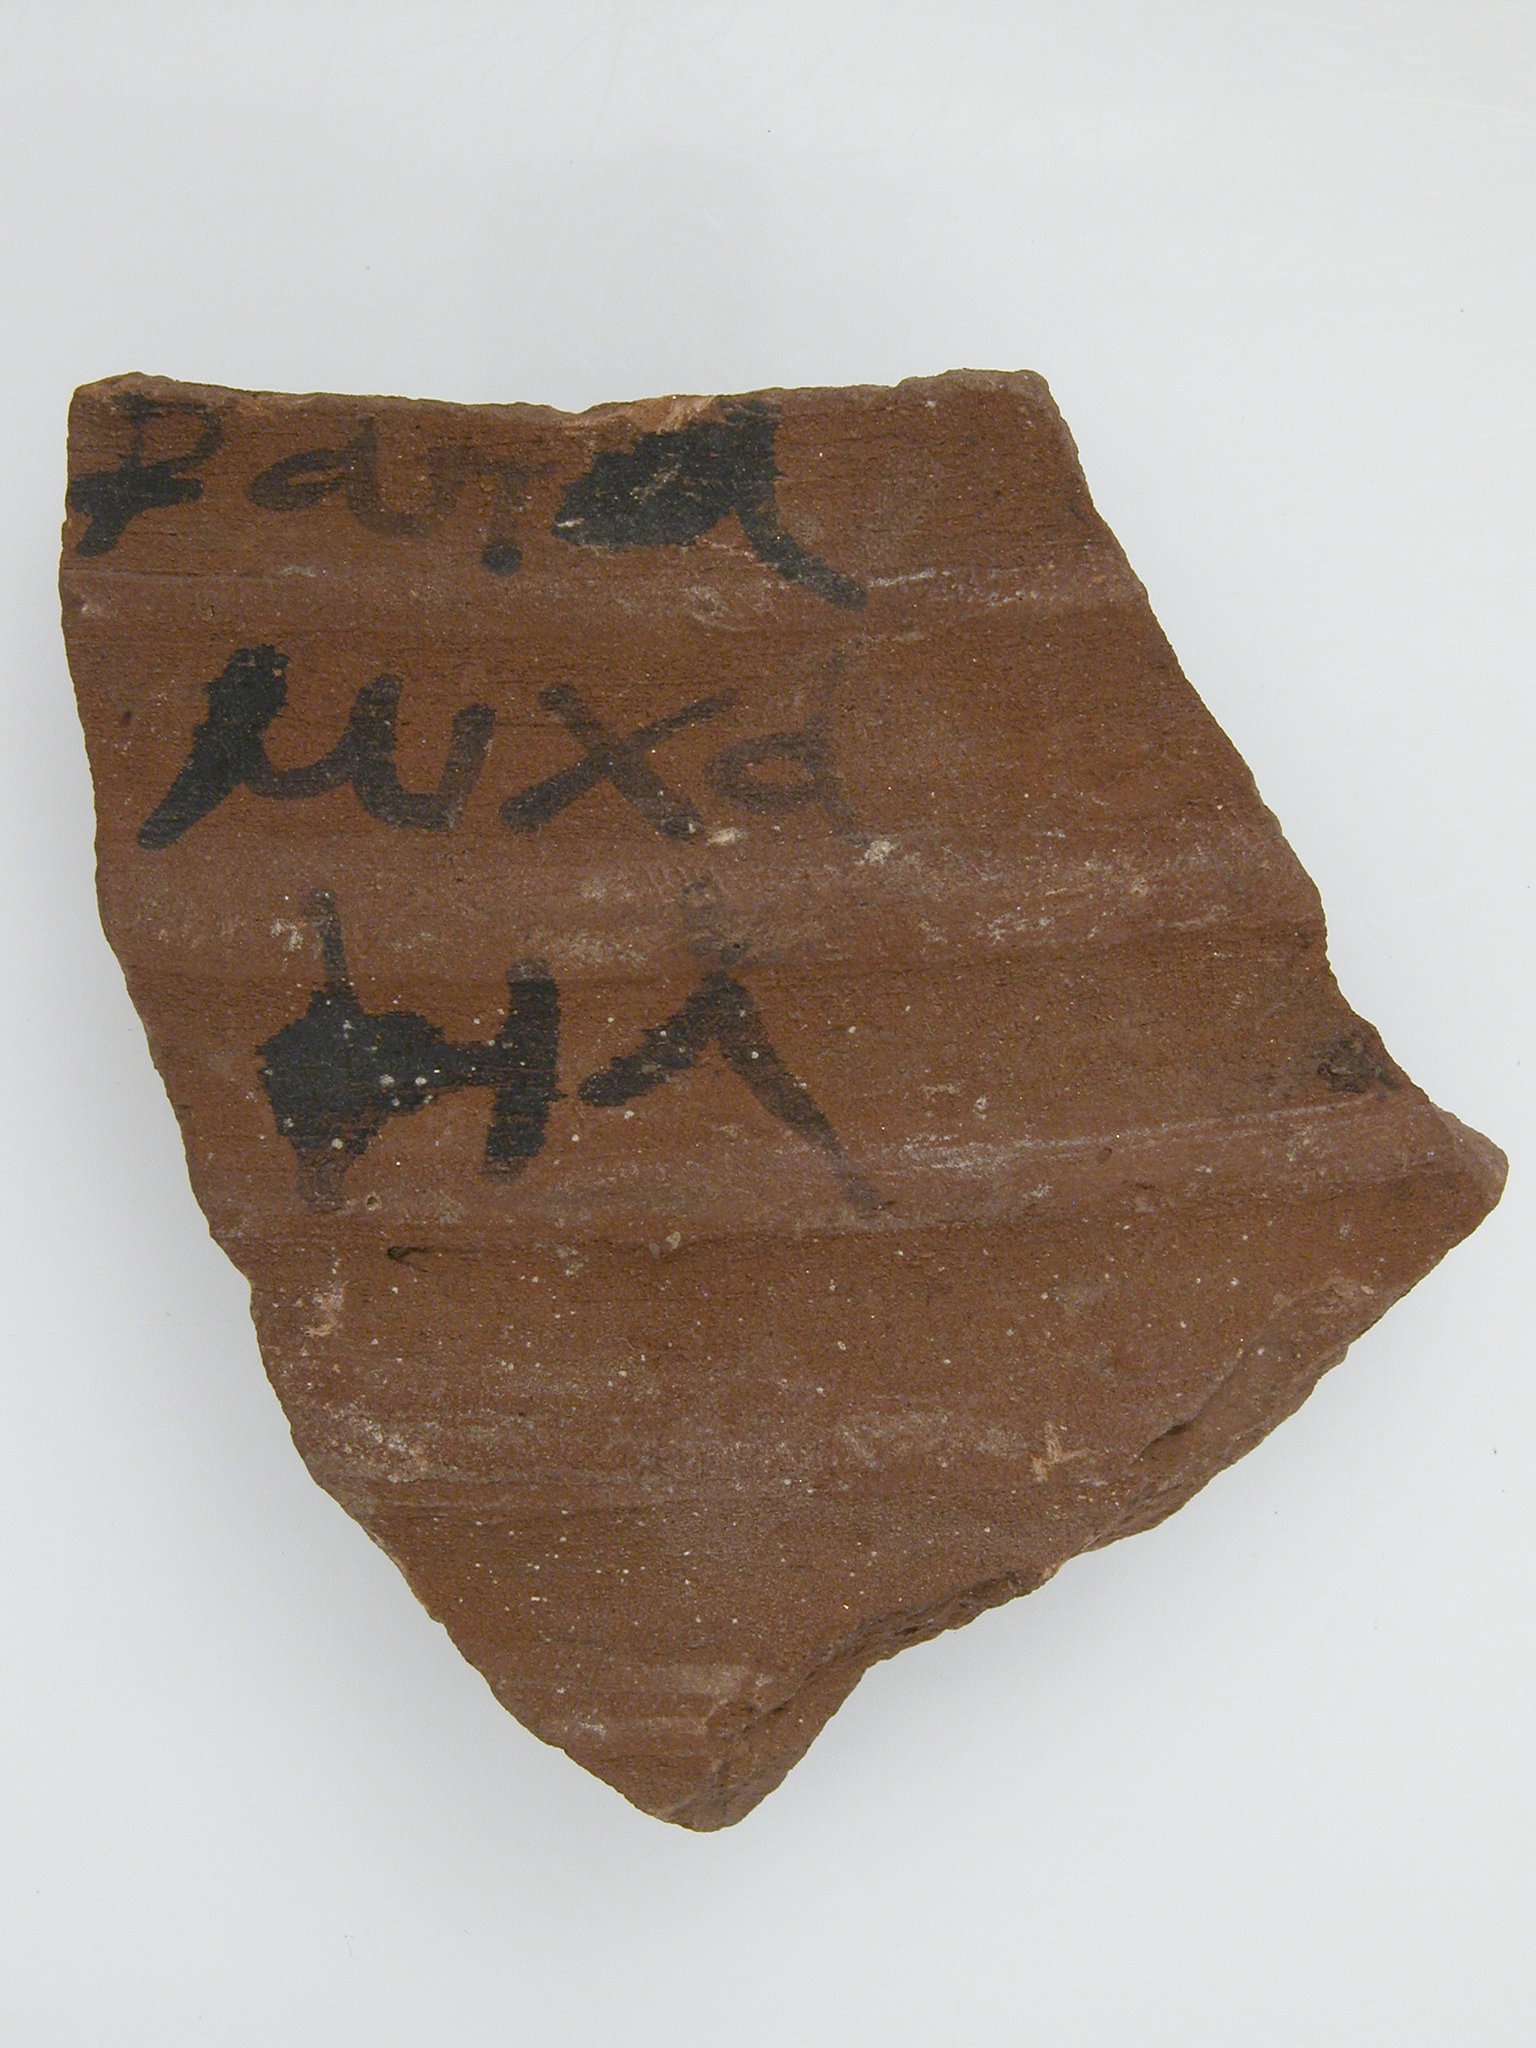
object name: ostrakon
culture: coptic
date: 601-700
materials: ink, pottery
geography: egypt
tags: documents